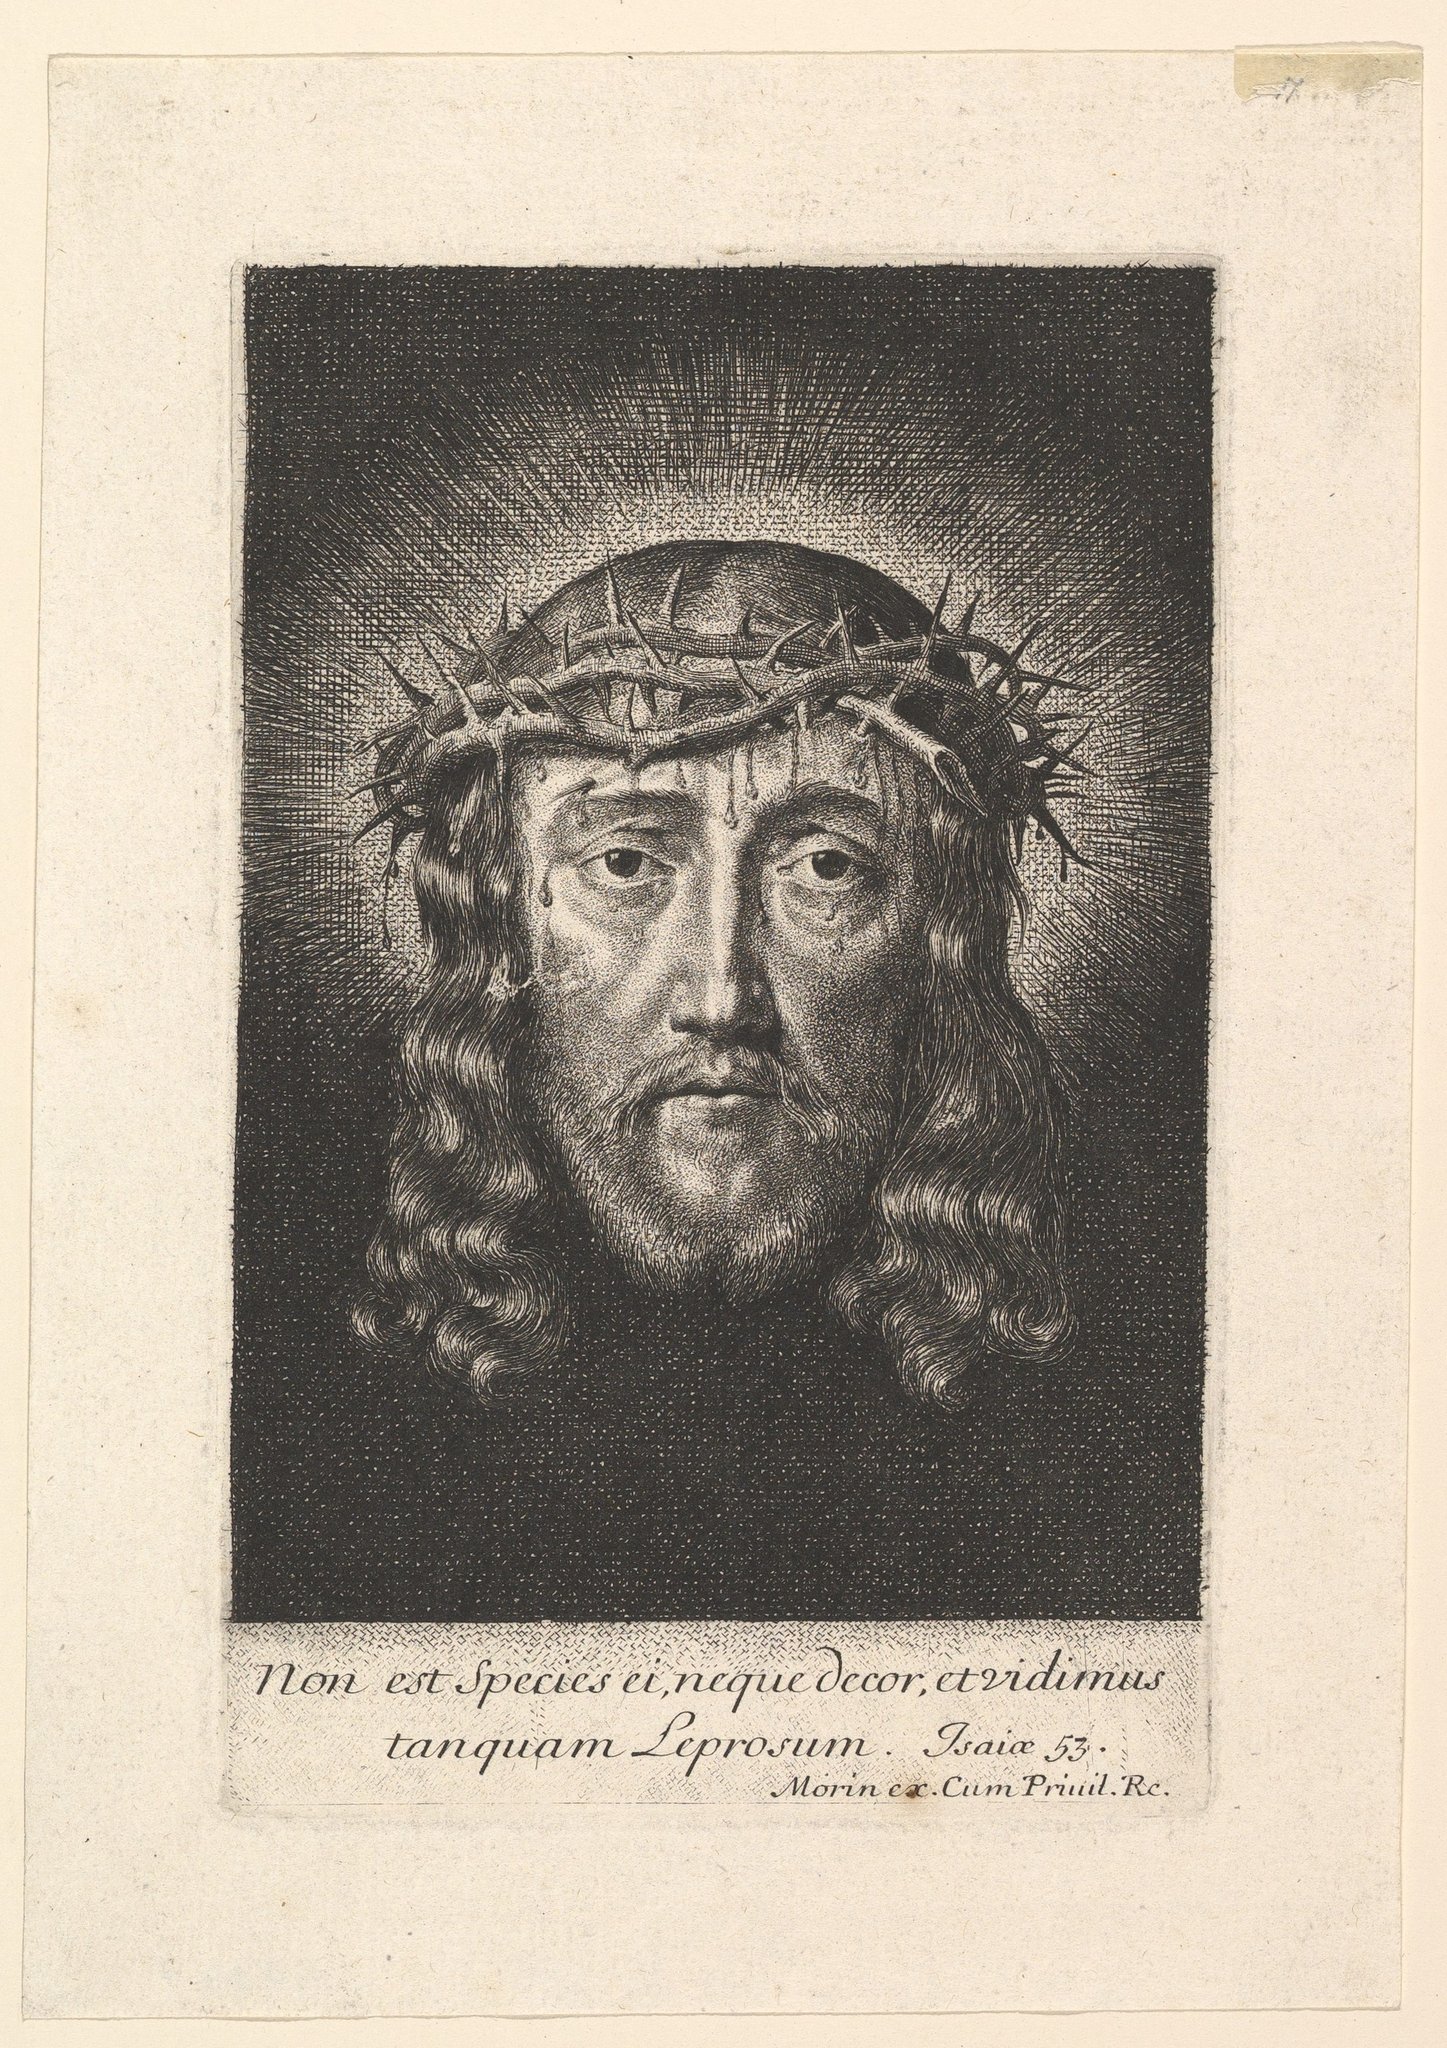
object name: print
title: La sainte Face couronnee d'epines, (petit format)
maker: jean morin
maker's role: artist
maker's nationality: french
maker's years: 1605-1650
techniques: etching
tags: faces,christ